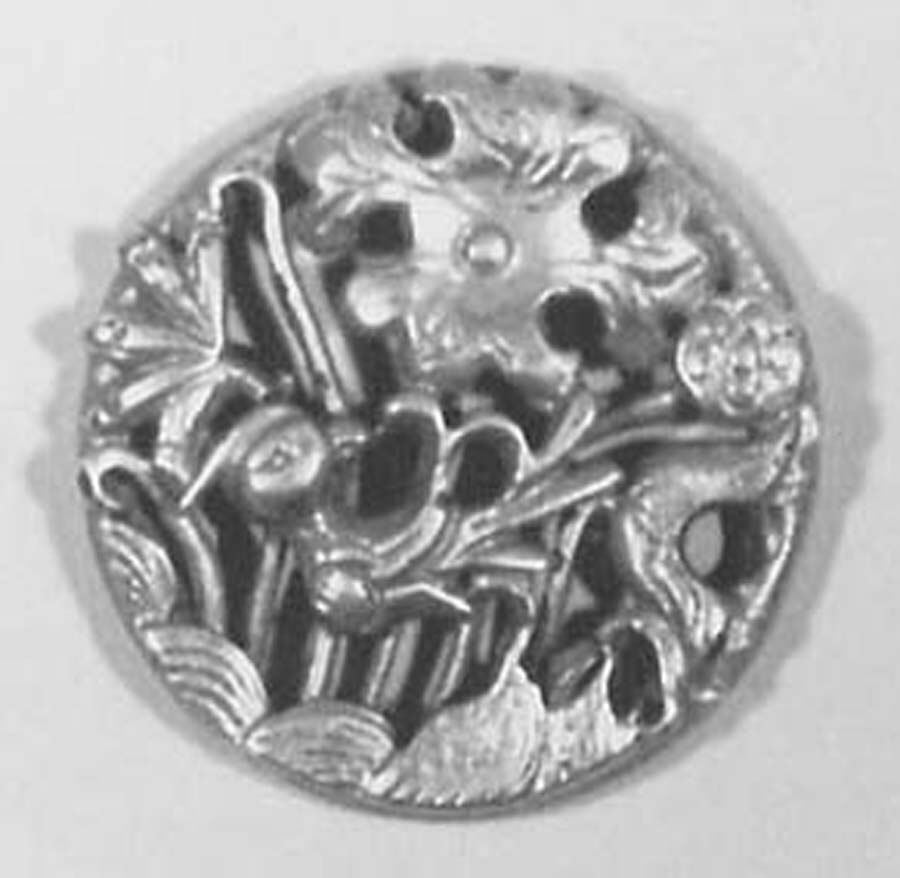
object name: ornament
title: Ornament with Decoration of Bird among Lotuses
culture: korean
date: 918-1392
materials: gold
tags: birds,lotuses